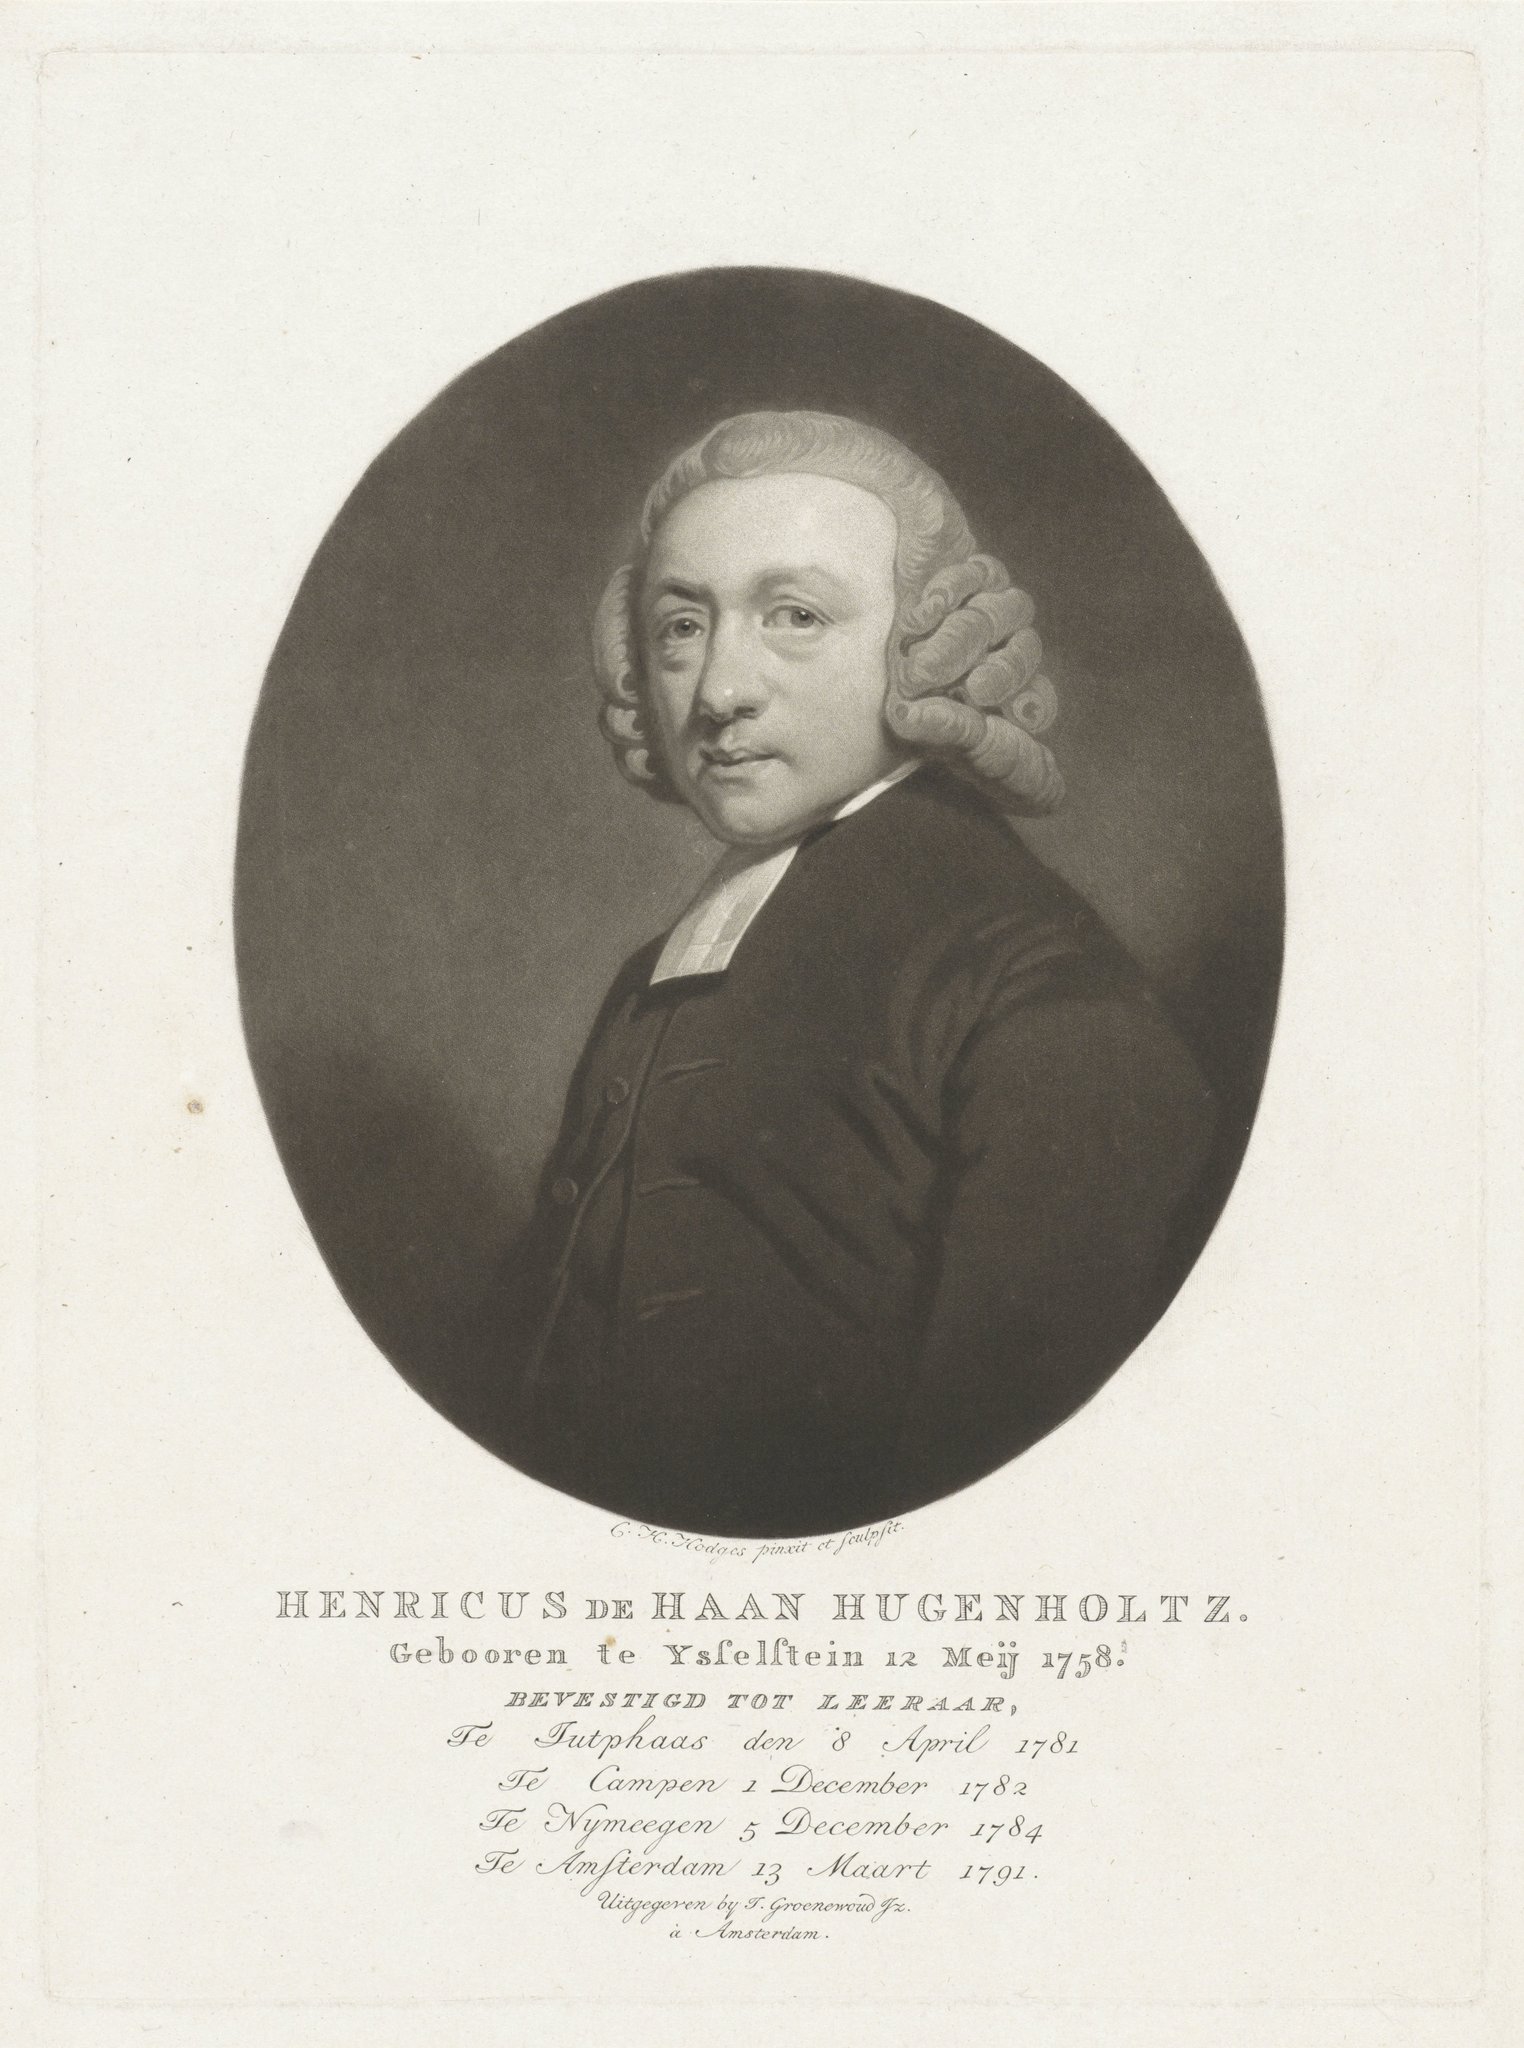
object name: print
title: Portret van de predikant Henricus de Haan Hugenholtz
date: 1804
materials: paper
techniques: engraving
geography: amsterdam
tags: wig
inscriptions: collector's mark: Lugt 2228